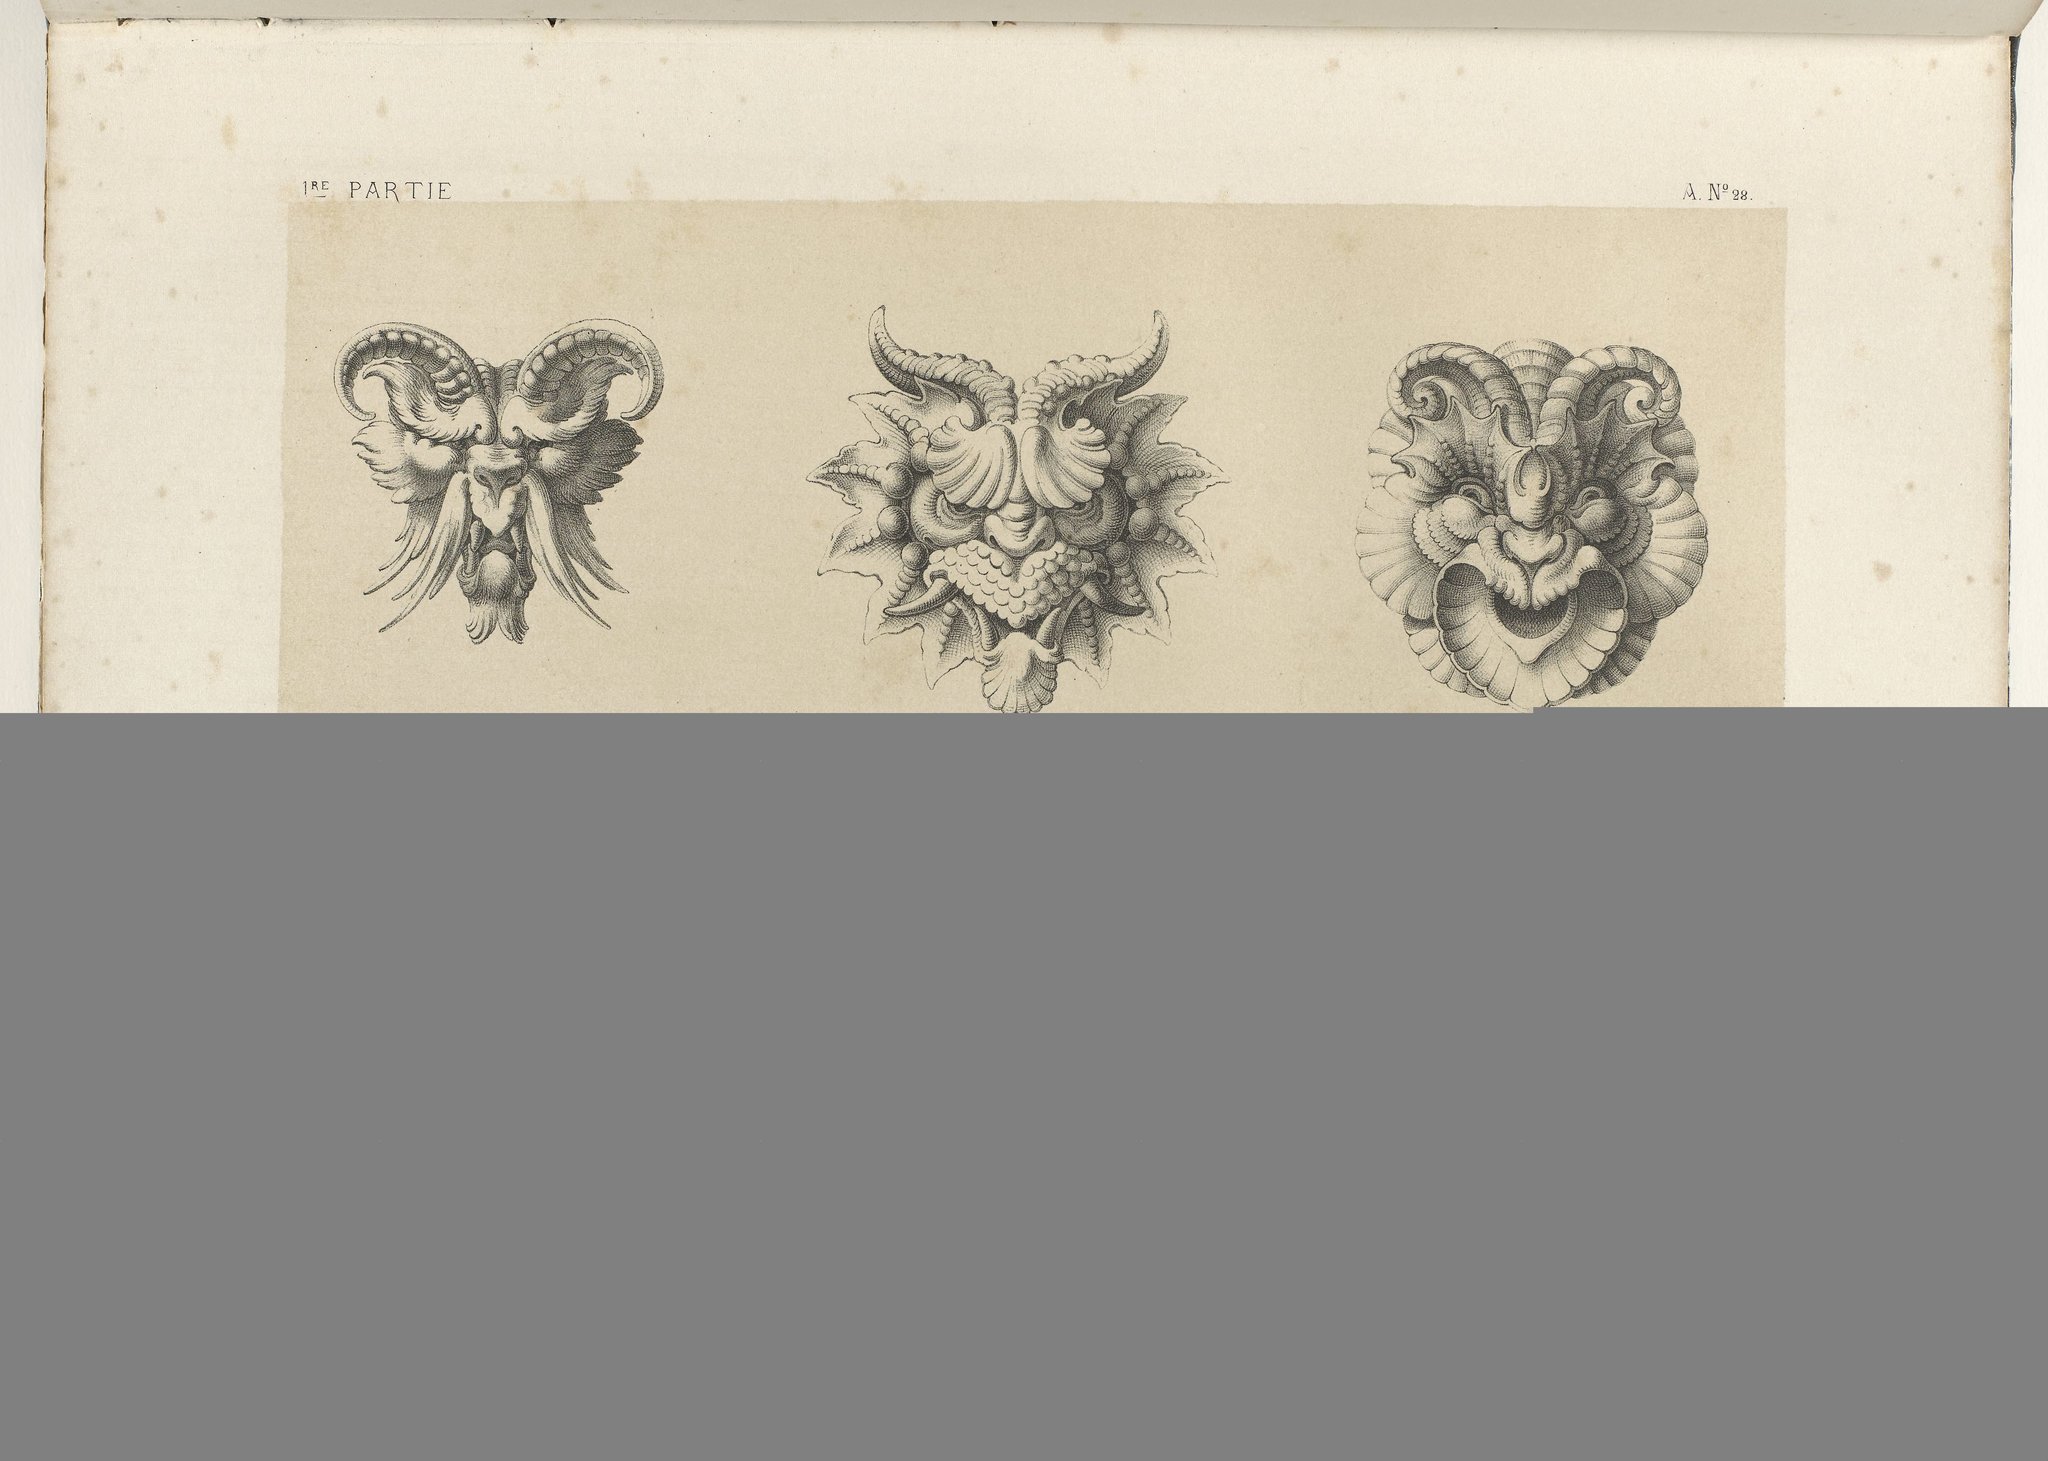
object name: print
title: Zes mascarons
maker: michel liénard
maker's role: print maker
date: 1866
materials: paper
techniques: tone lithography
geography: liège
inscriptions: annotation: ‘Mascarons Chimèriques (Hersenschimmig)’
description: Mascarons van Chimaeren. Linksboven: 1re partie, rechtsboven: A. N° 28., linksonder: 124.